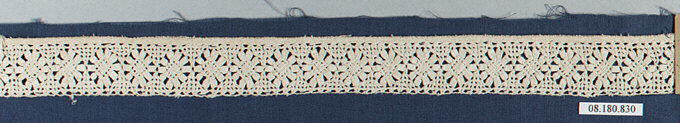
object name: insertion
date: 1701-1800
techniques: lace